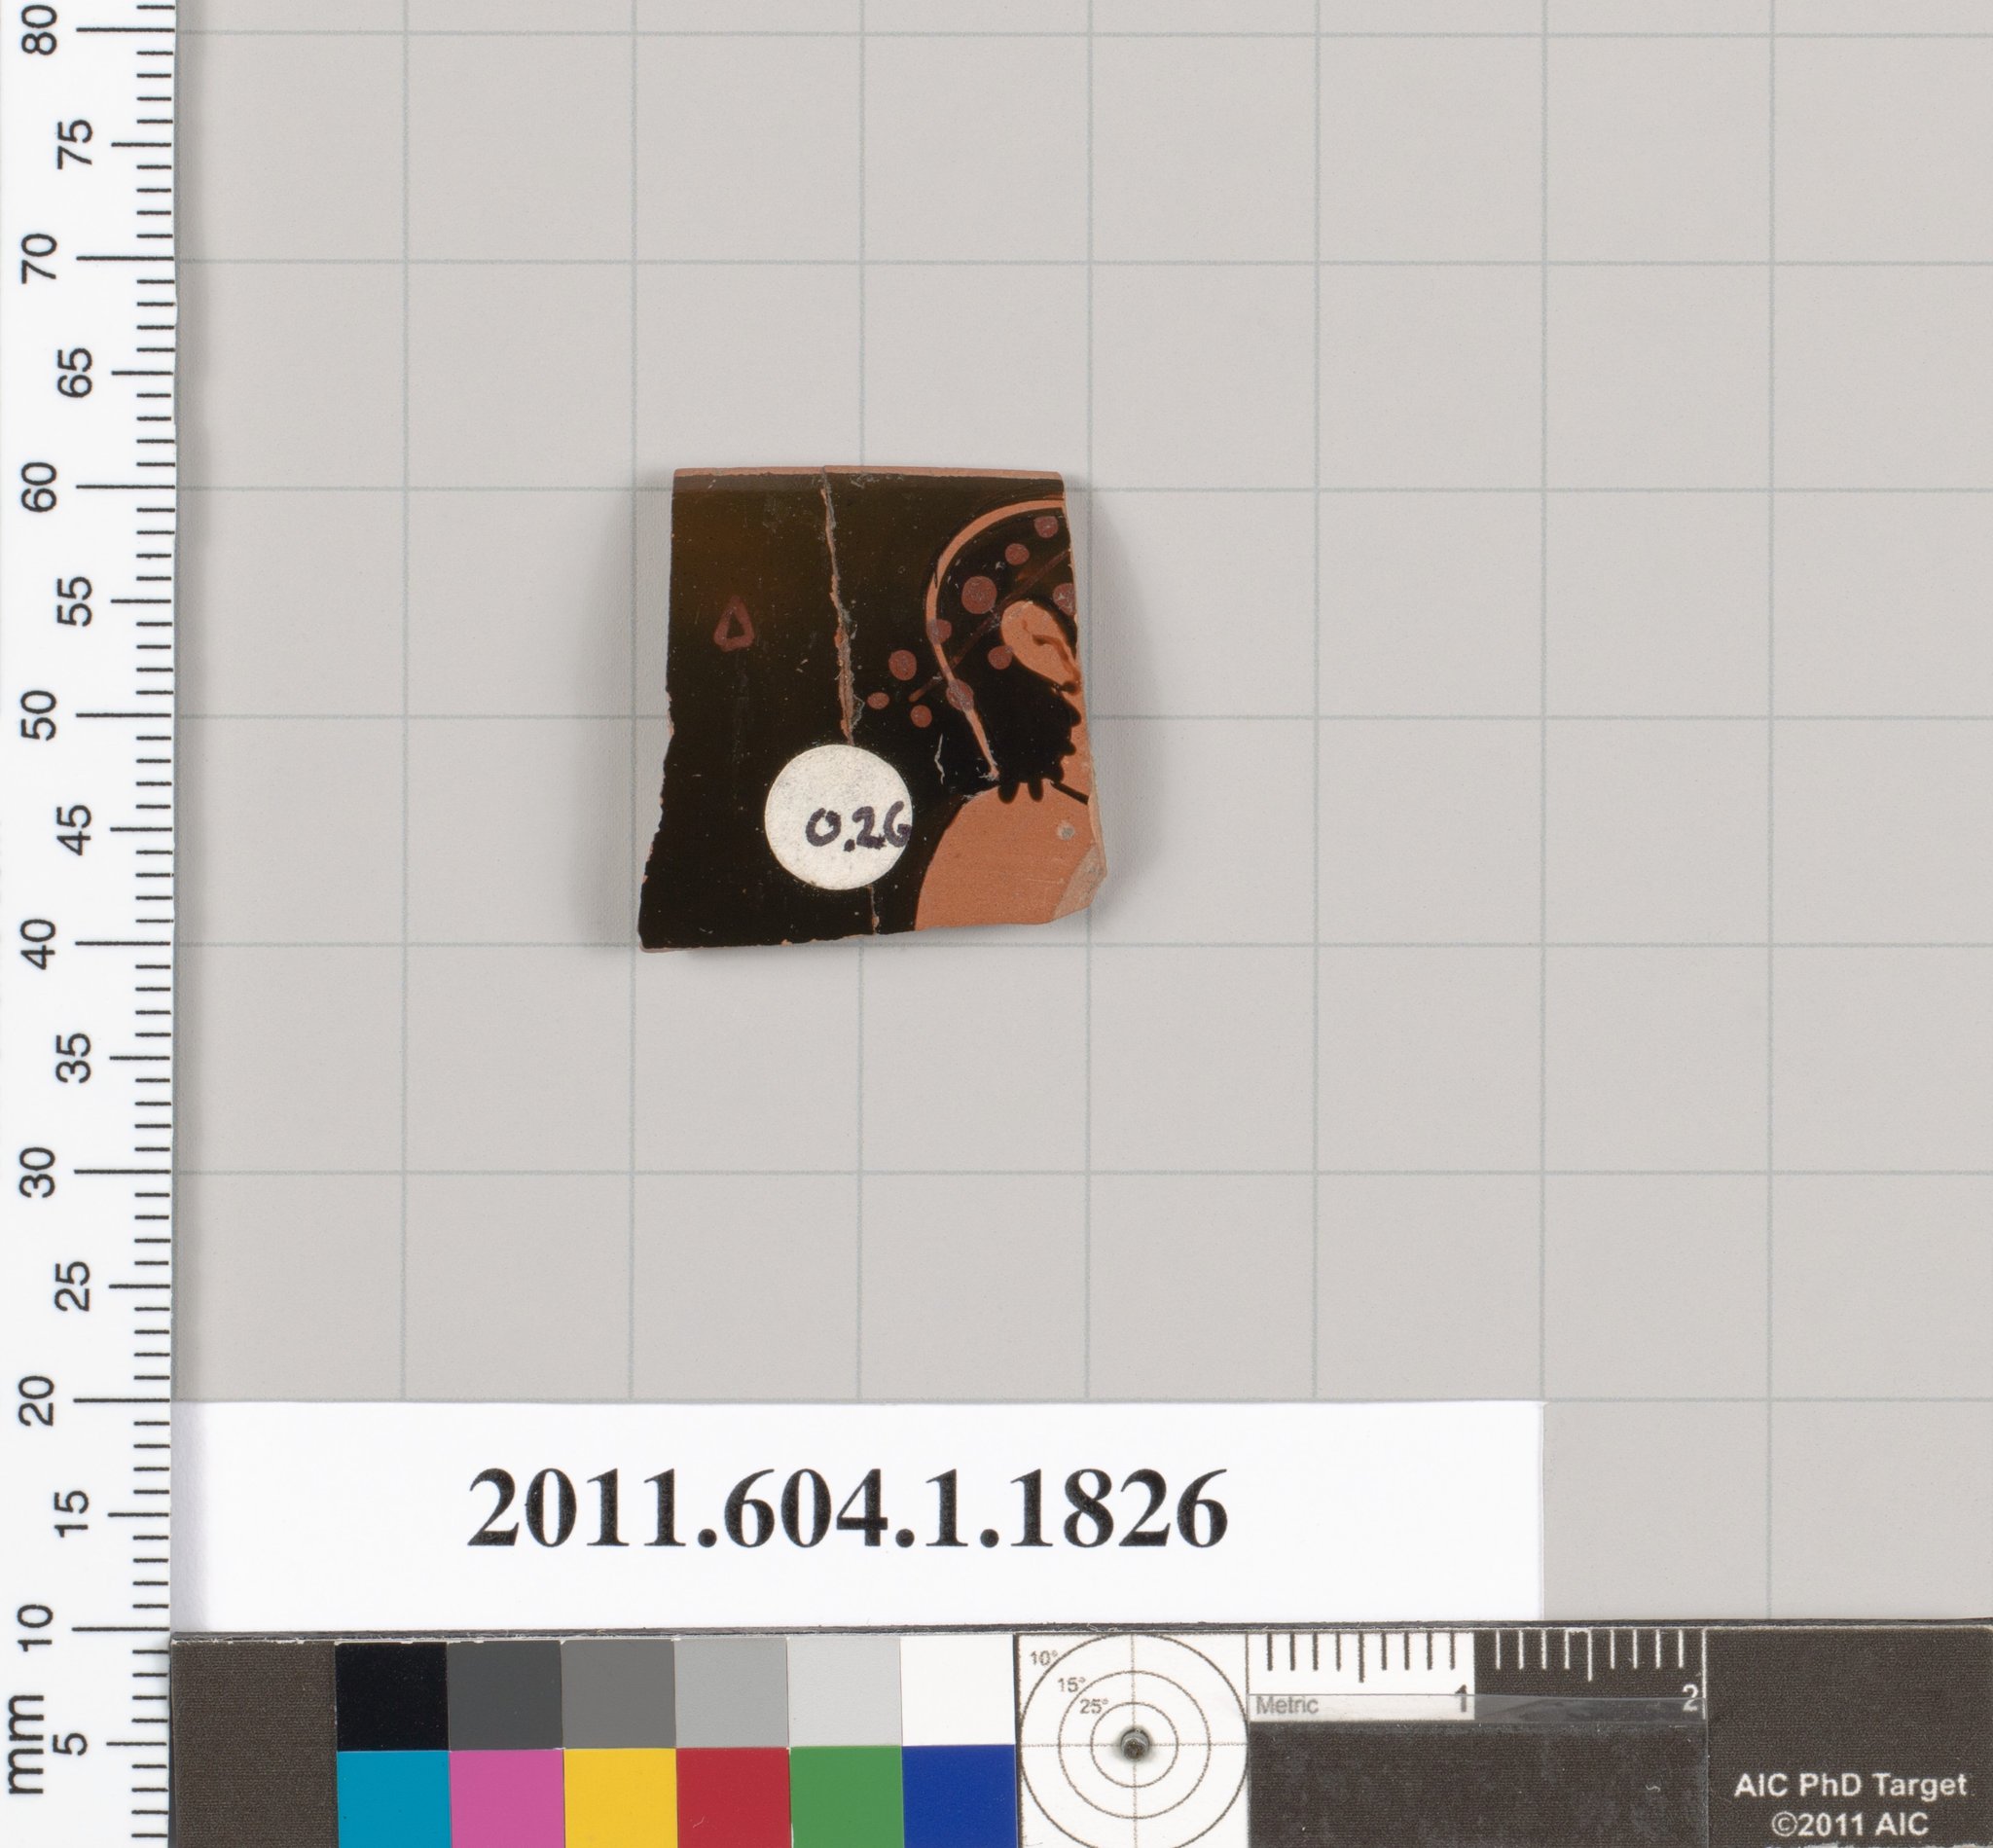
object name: kylix fragment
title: Terracotta rim fragment of a kylix (drinking cup)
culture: greek, attic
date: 534-468 BCE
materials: terracotta